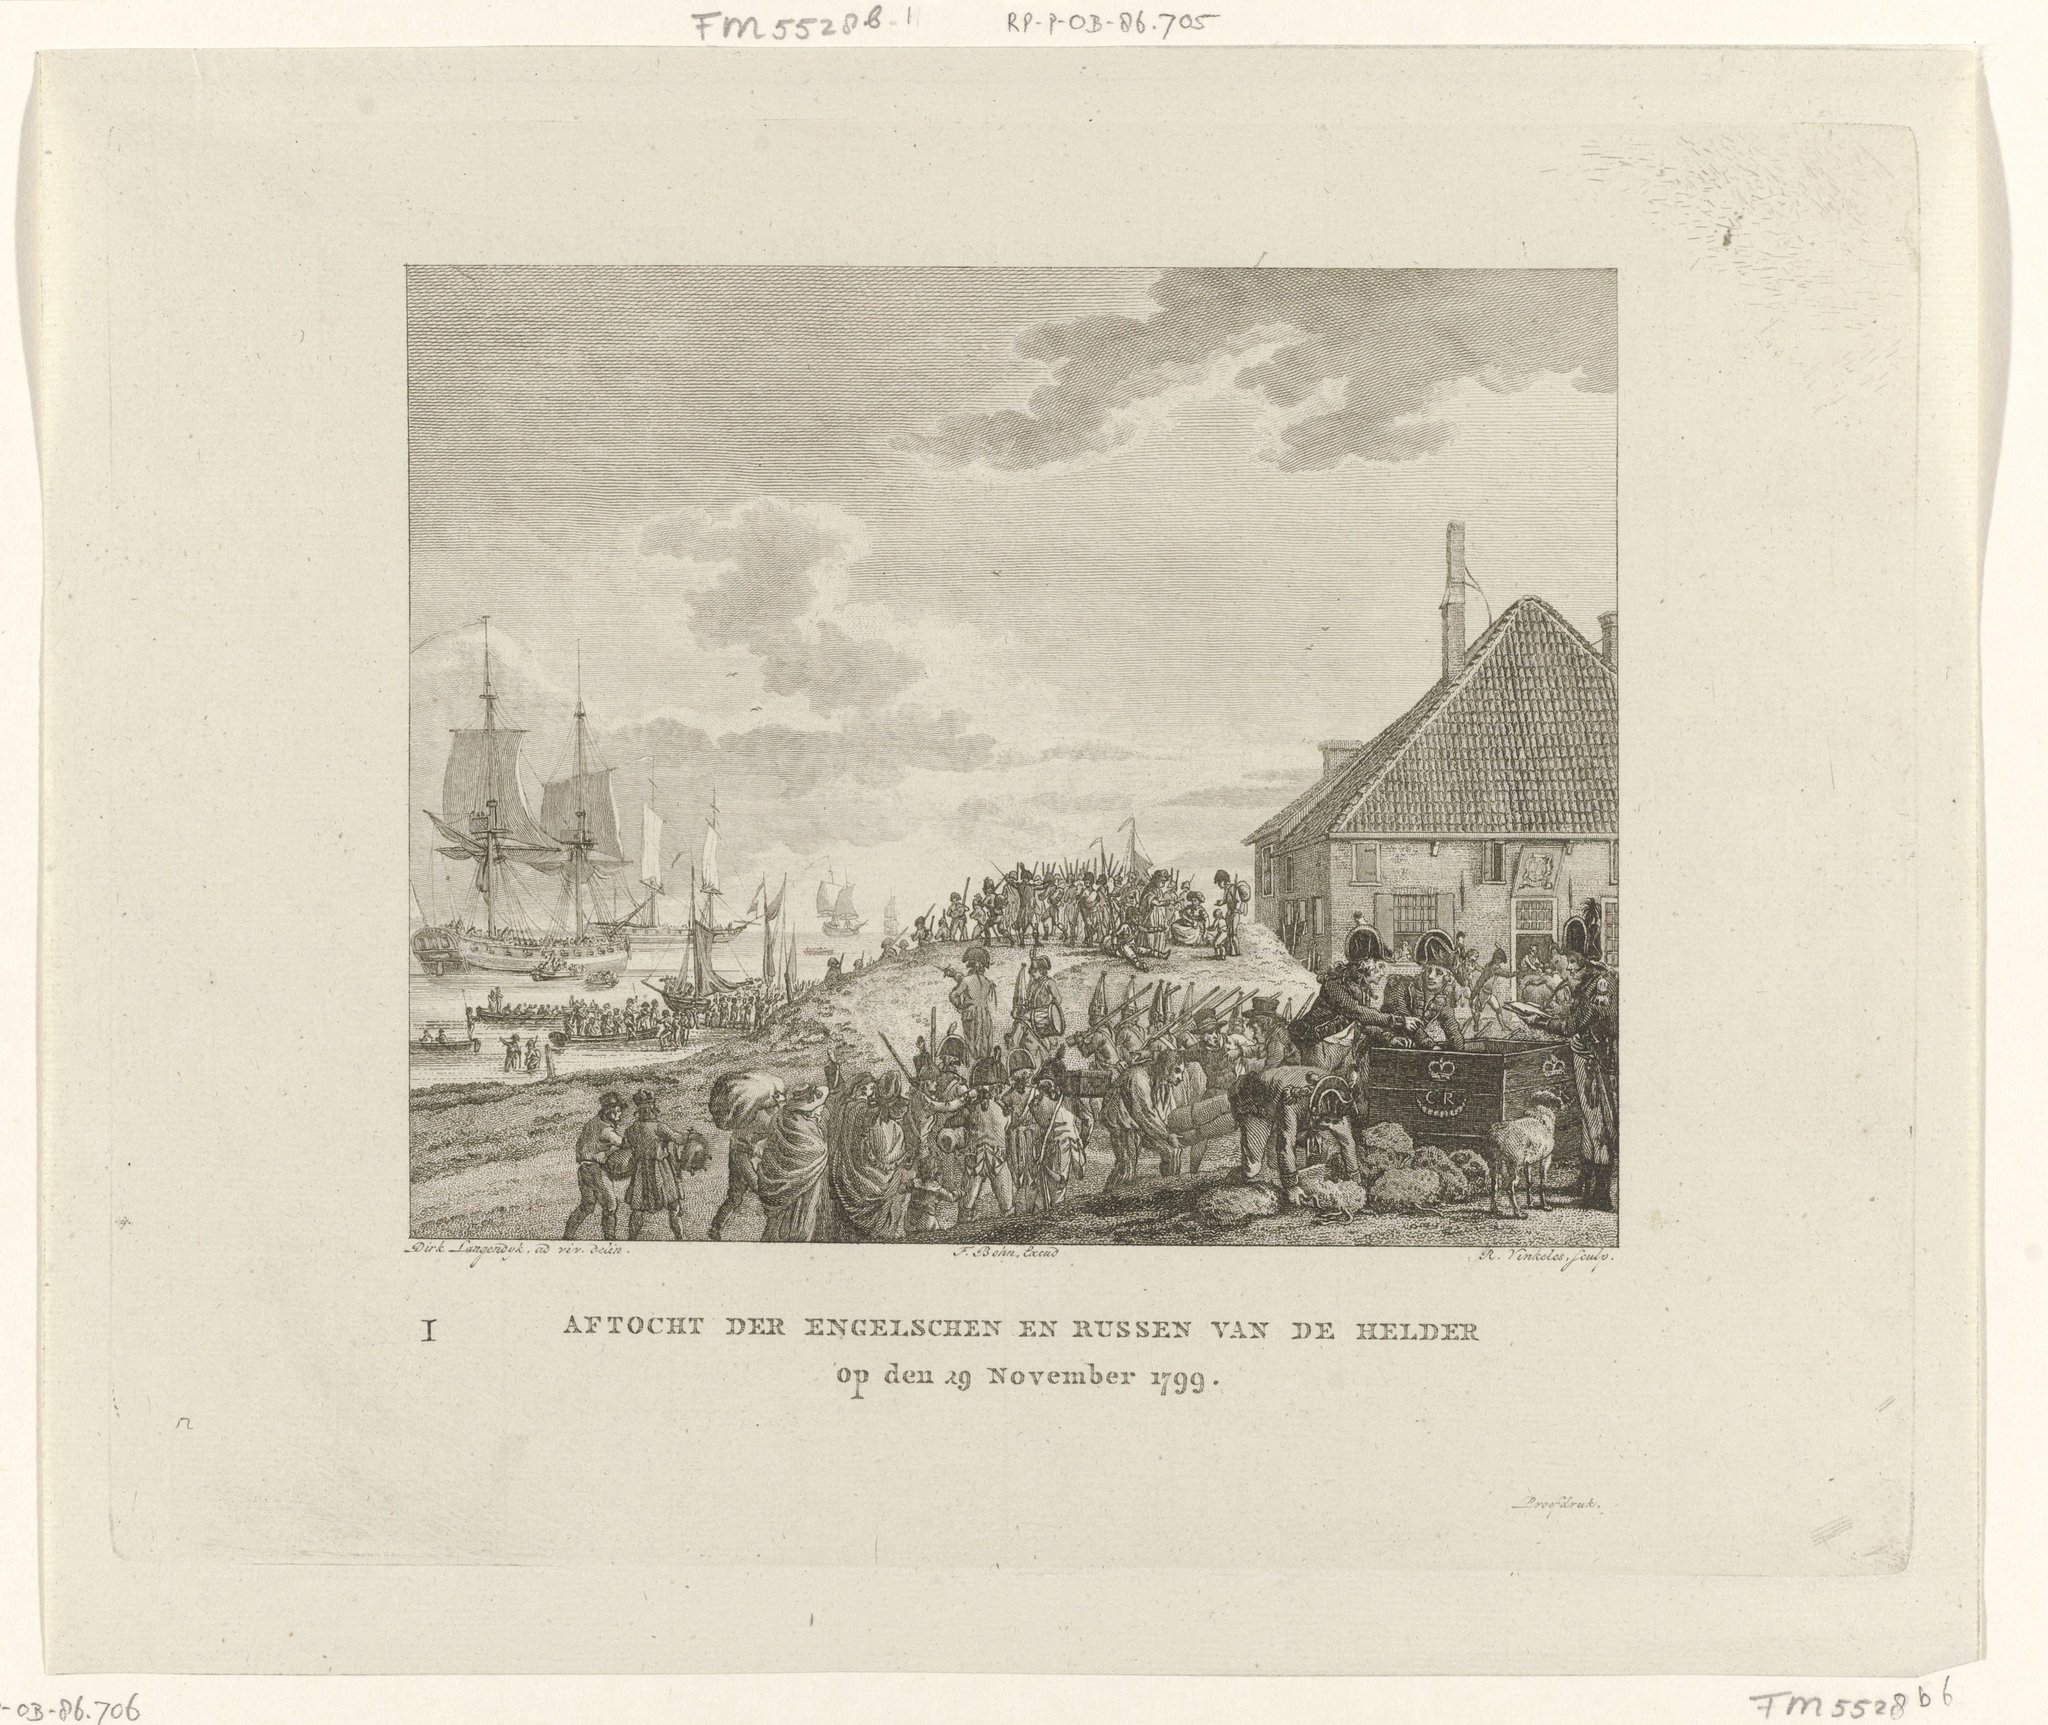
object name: print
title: Aftocht der Engelschen en Russen van De Helder Op den 29 November 1799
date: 1800-1802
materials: paper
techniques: engraving, etching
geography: haarlem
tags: transport, train (military) (+ sailing-ships), den helder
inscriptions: collector's mark: Lugt 2228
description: De soldaten van de Brits-Russische invasiemacht verlaten Den Helder op 29 november 1799. Op de voorgrond wordt een grote kist met het gekroonde monogram GR ingepakt. Op de achtergrond vertrekken manschappen in sloepen naar de gereedliggende schepen. Gemerkt linksonder met de letter I.